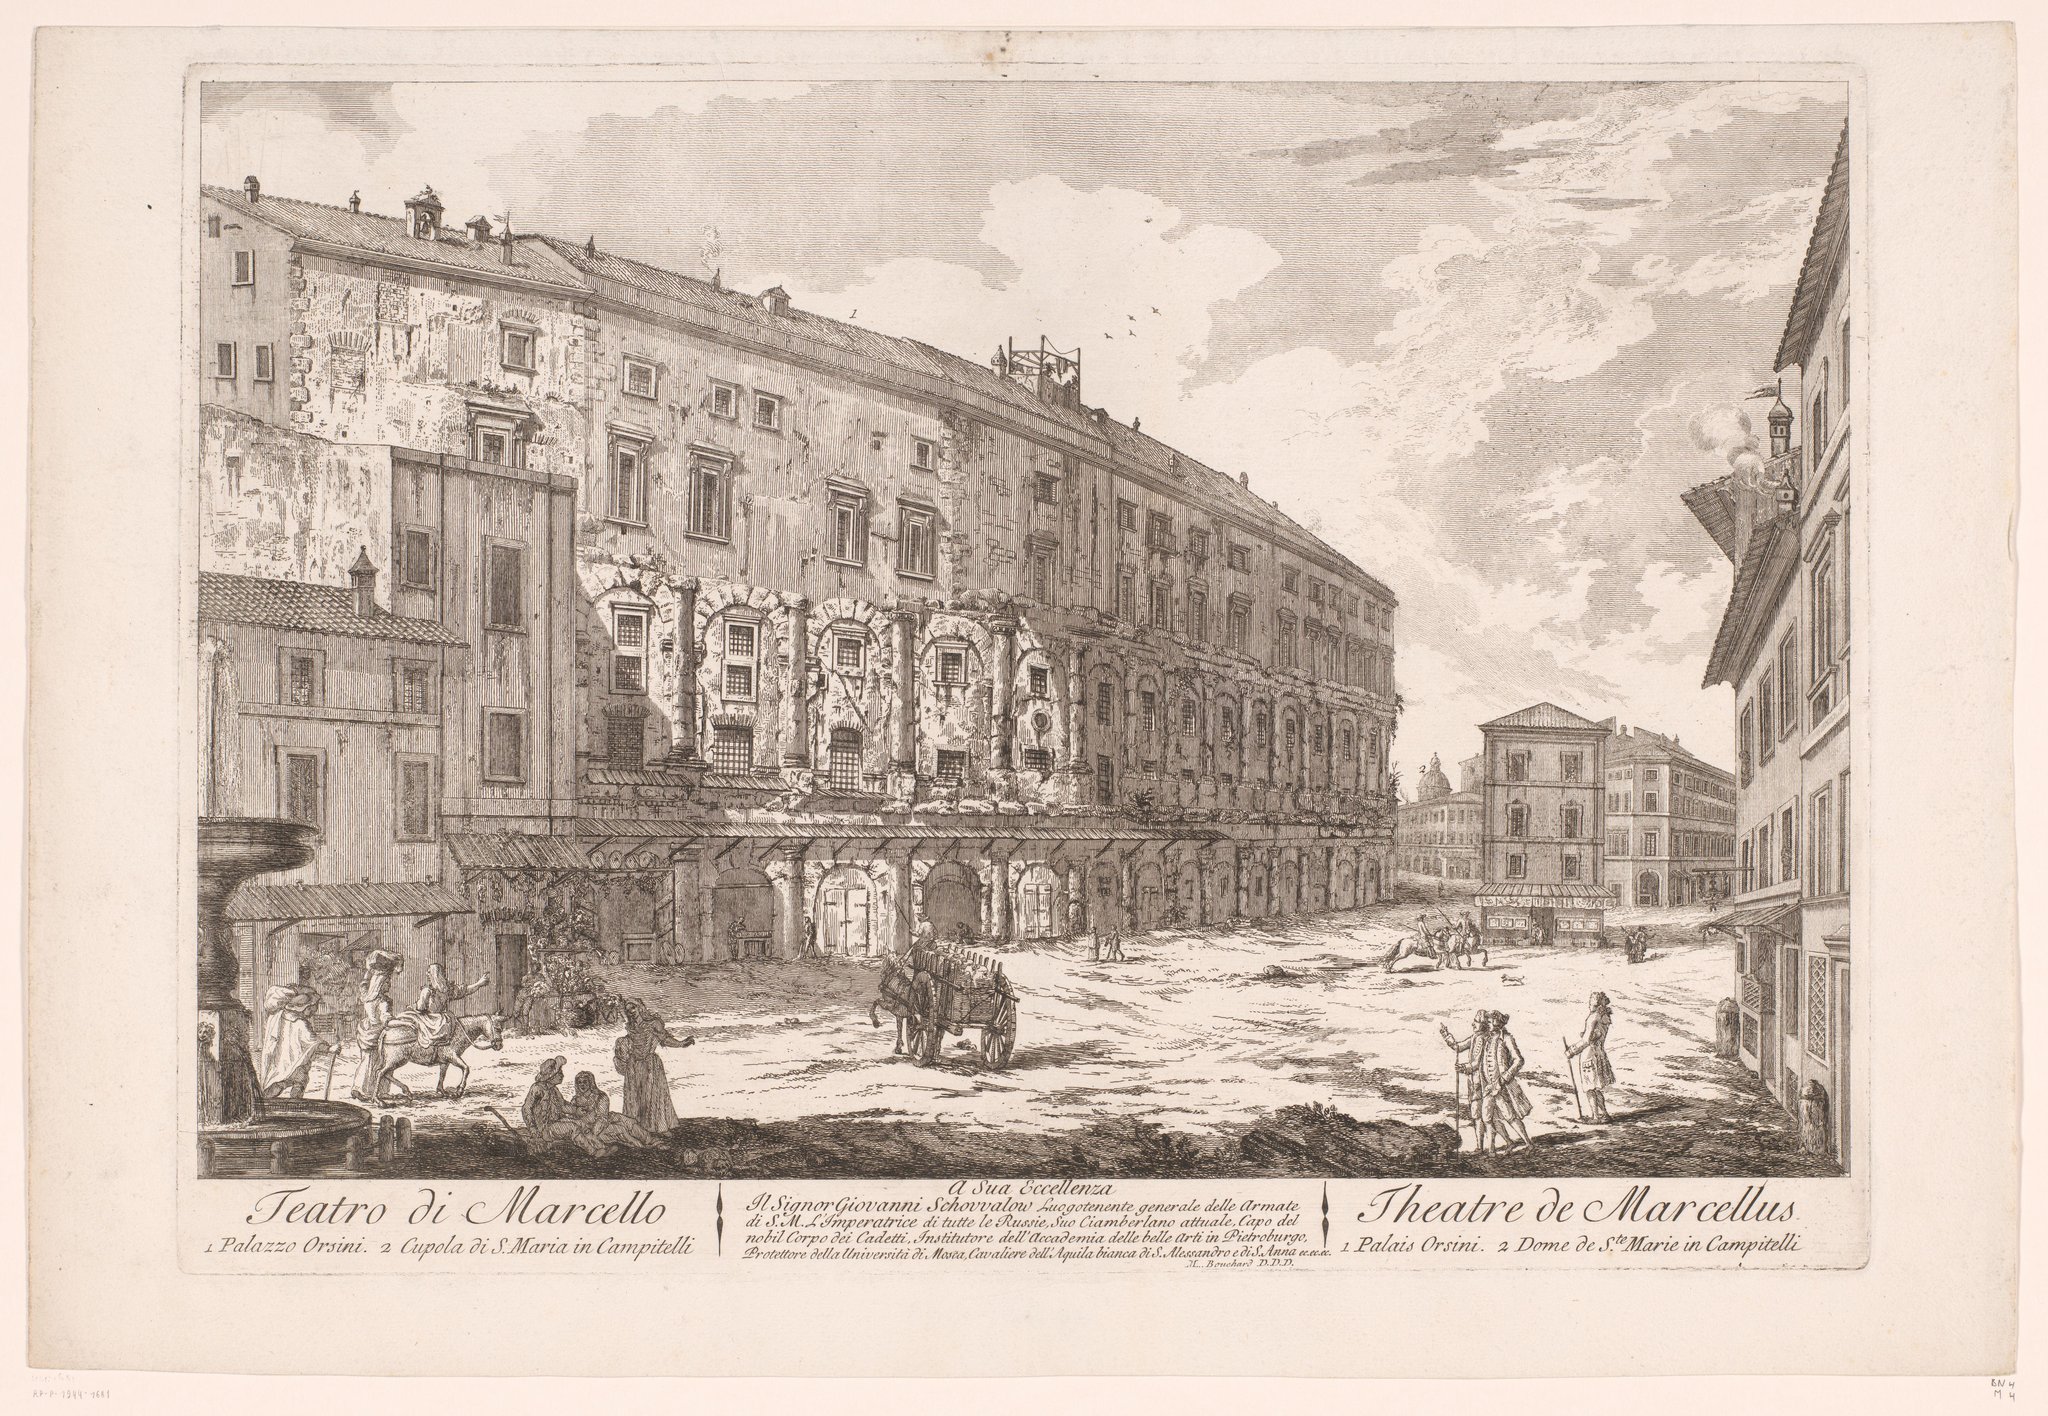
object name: print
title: Gezicht op het theater van Marcellus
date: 1761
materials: paper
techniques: etching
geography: rome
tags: theatre (building)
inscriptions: collector's mark: Lugt 2228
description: Prent uit: Les plus beaux monuments de Rome ancienne, ou Recueil des plus beaux morceaux de l'antiquité romaine (...). Rome: Bouchard en Gravier, 1761.